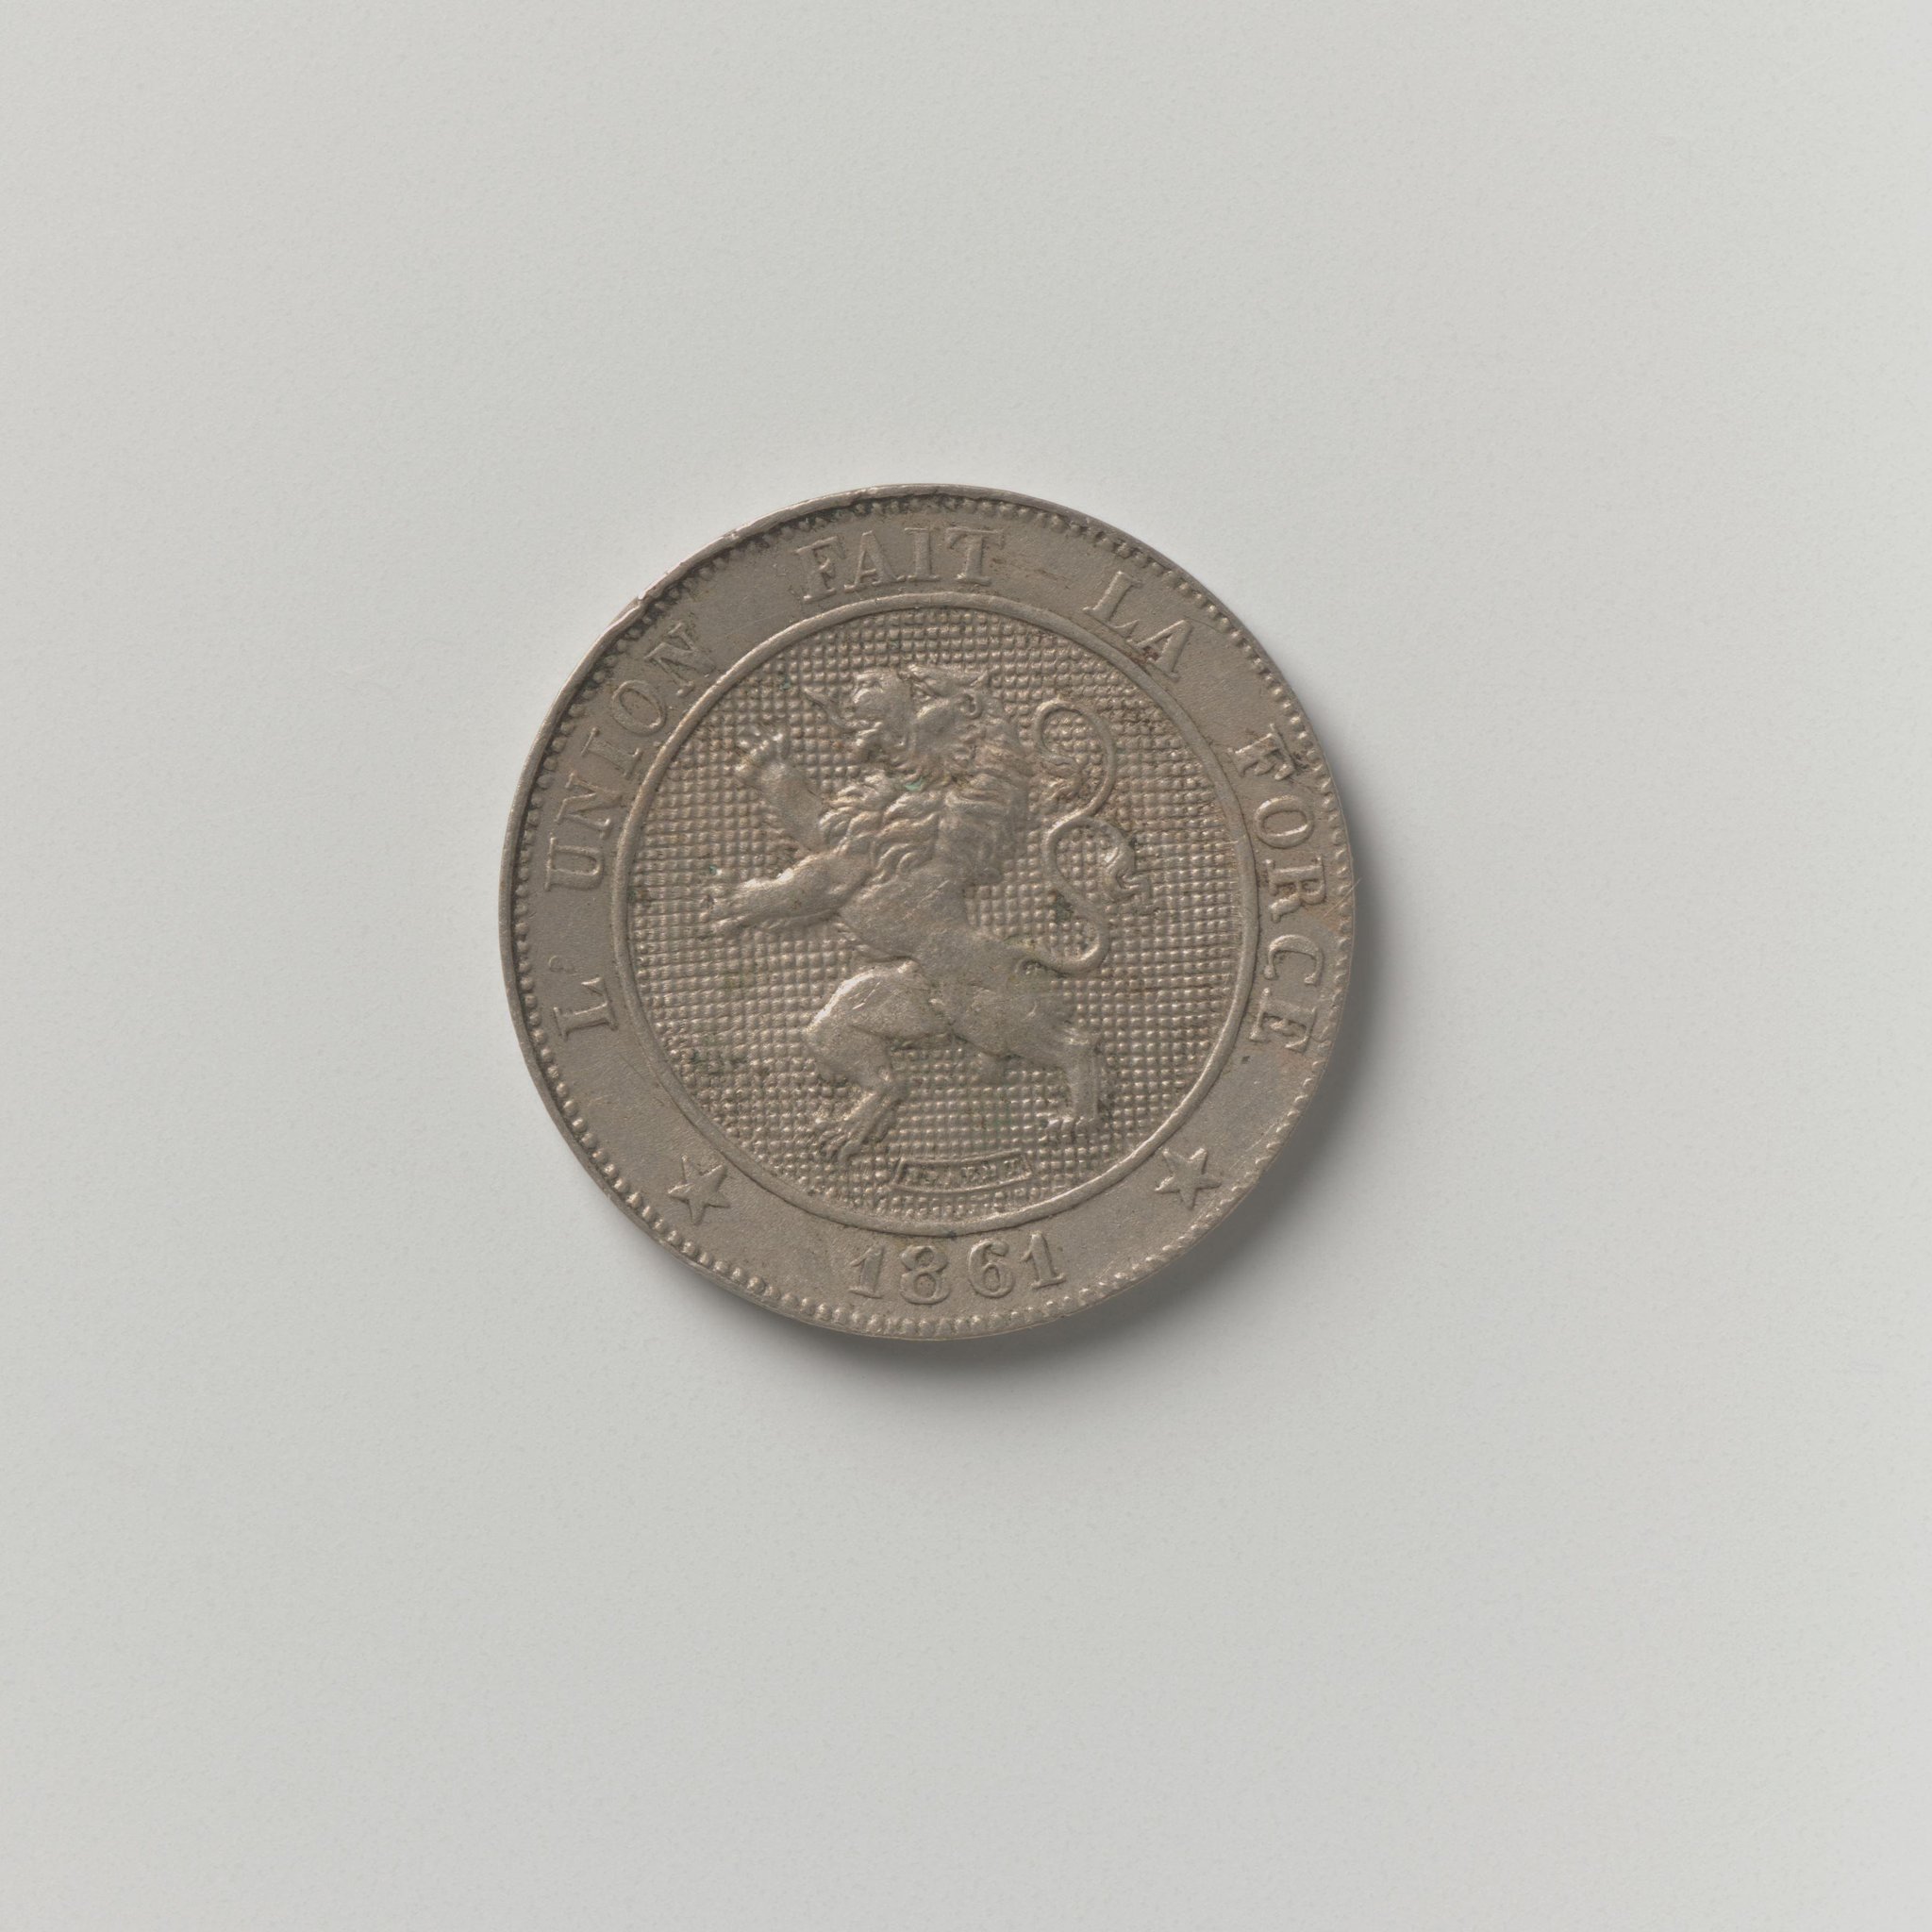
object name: coin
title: 5 centimes uit België van Leopold I, 1861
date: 1861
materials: nickel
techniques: striking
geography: brussels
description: Nikkelen munt. Voorzijde: in gearceerd veld waarde-aanduiding in twee regels, waaronder ster. Keerzijde: In gearceerd veld staande leeuw naar links. Jaartal onderaan. Inliggende kartelrand.